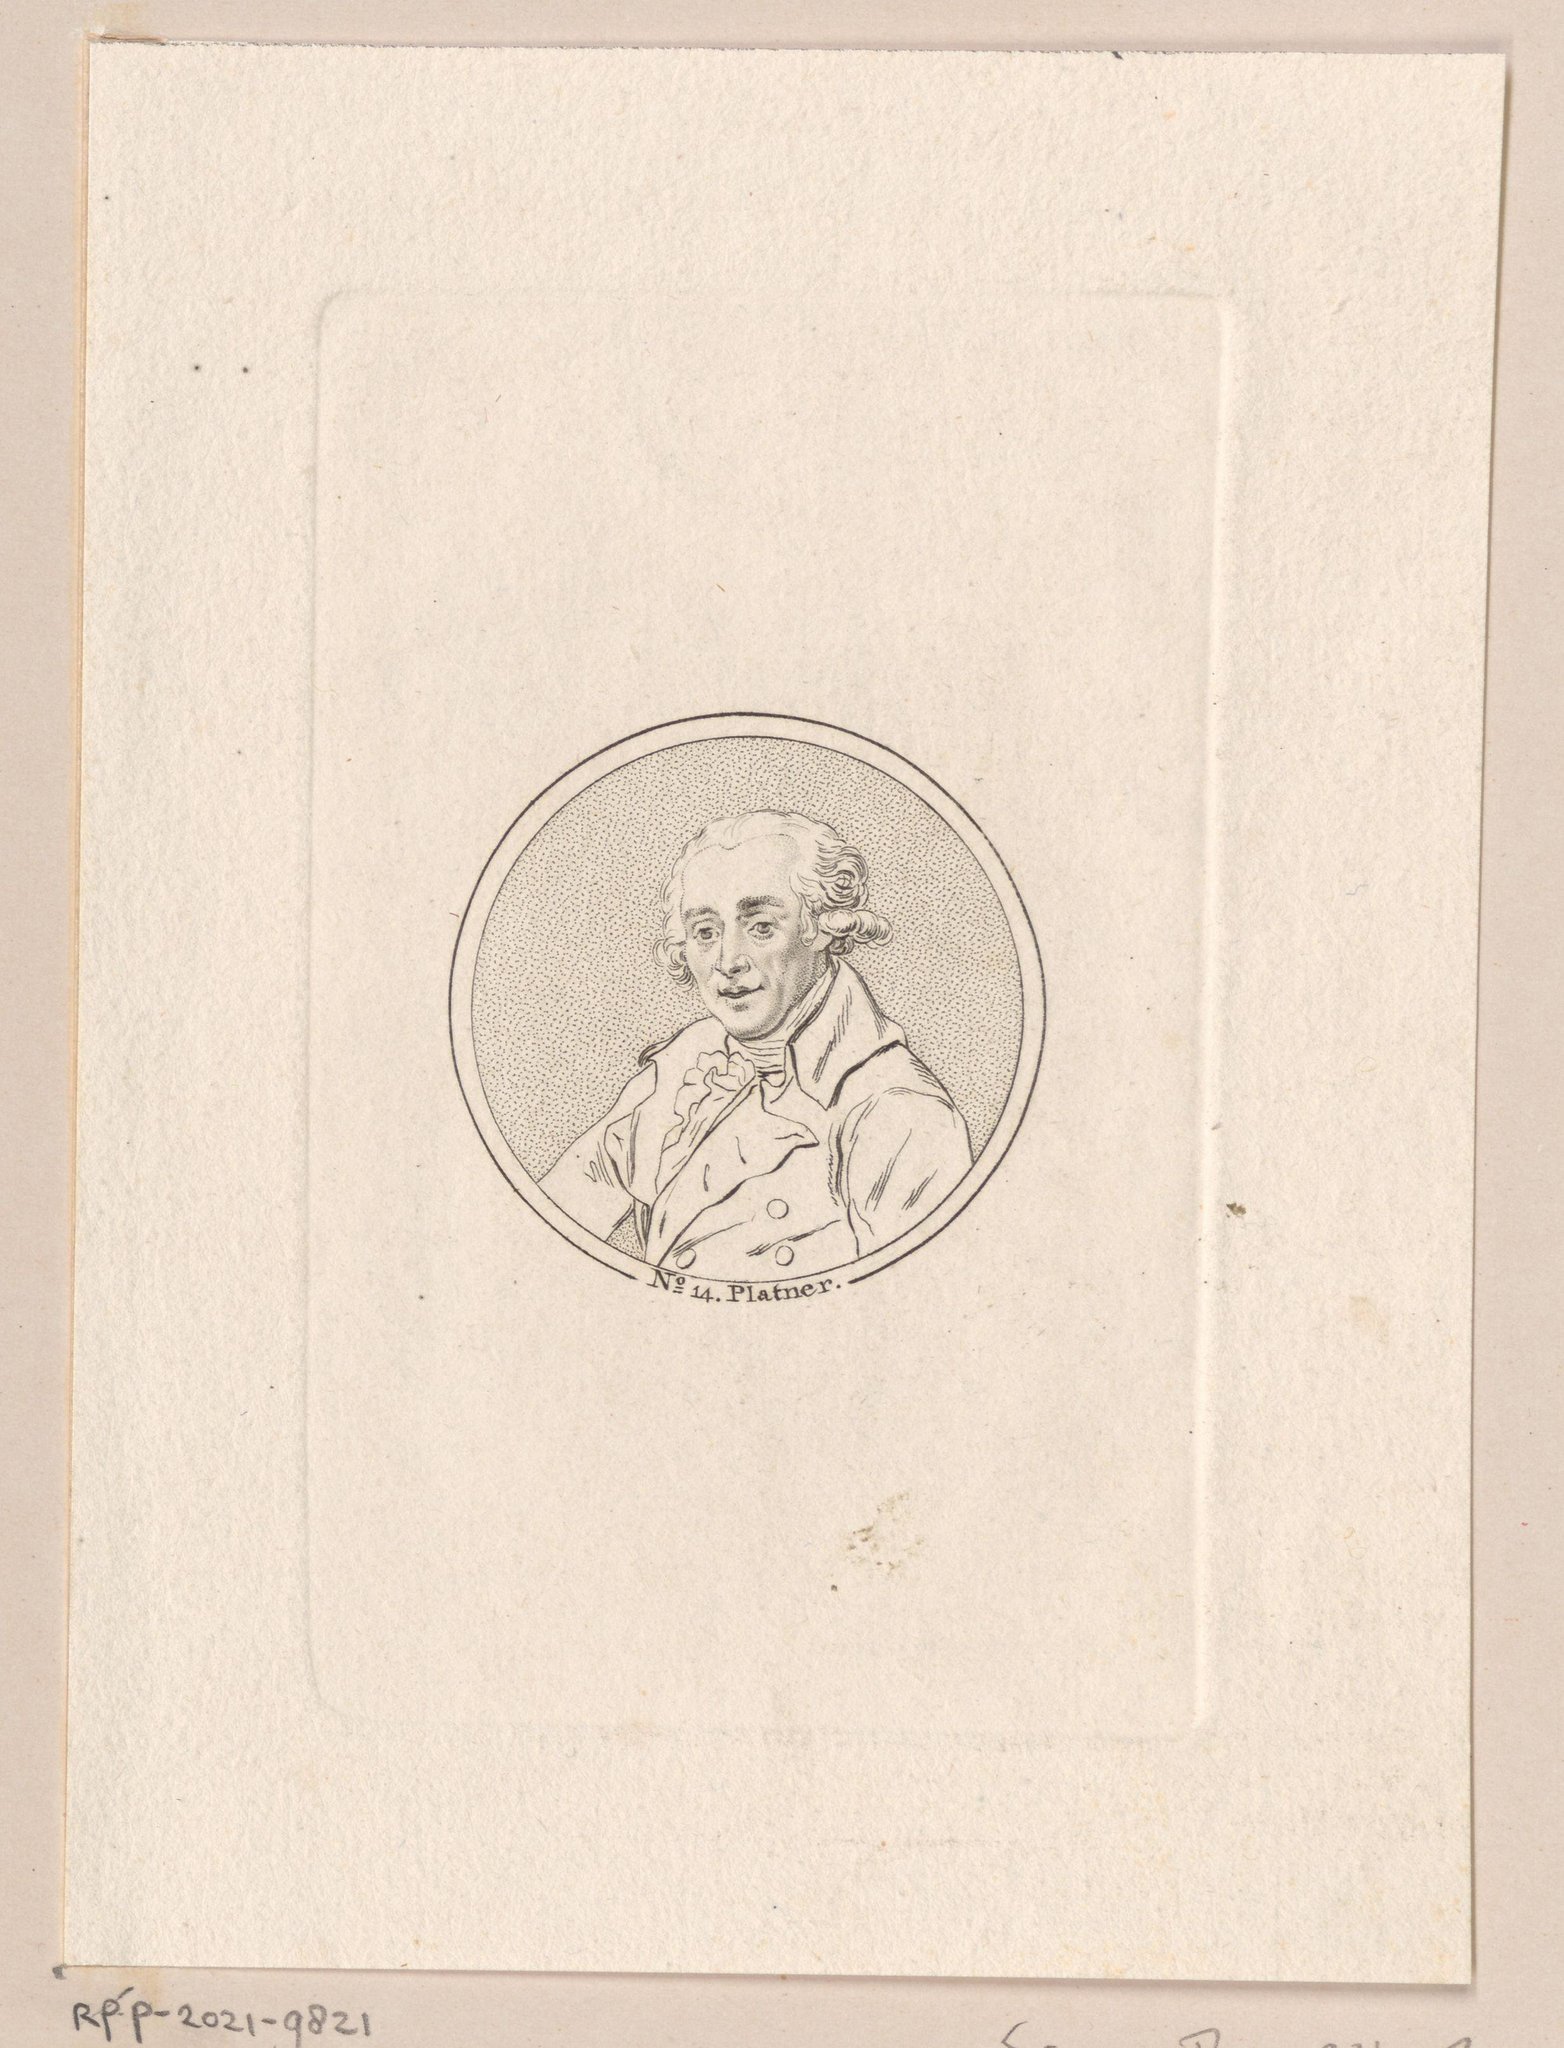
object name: print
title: Portret van Ernst Platner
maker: Anonymous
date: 1810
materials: paper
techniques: engraving, etching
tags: adult man, historical persons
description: Prent waarschijnlijk uit: Kreussler, Heinrich Gottlieb. Beschreibung der Feyerlichkeiten vom Jubelfeste der Universität Leipzig den 4. December 1809. Leipzig: Carl August Solbrig, 1810.